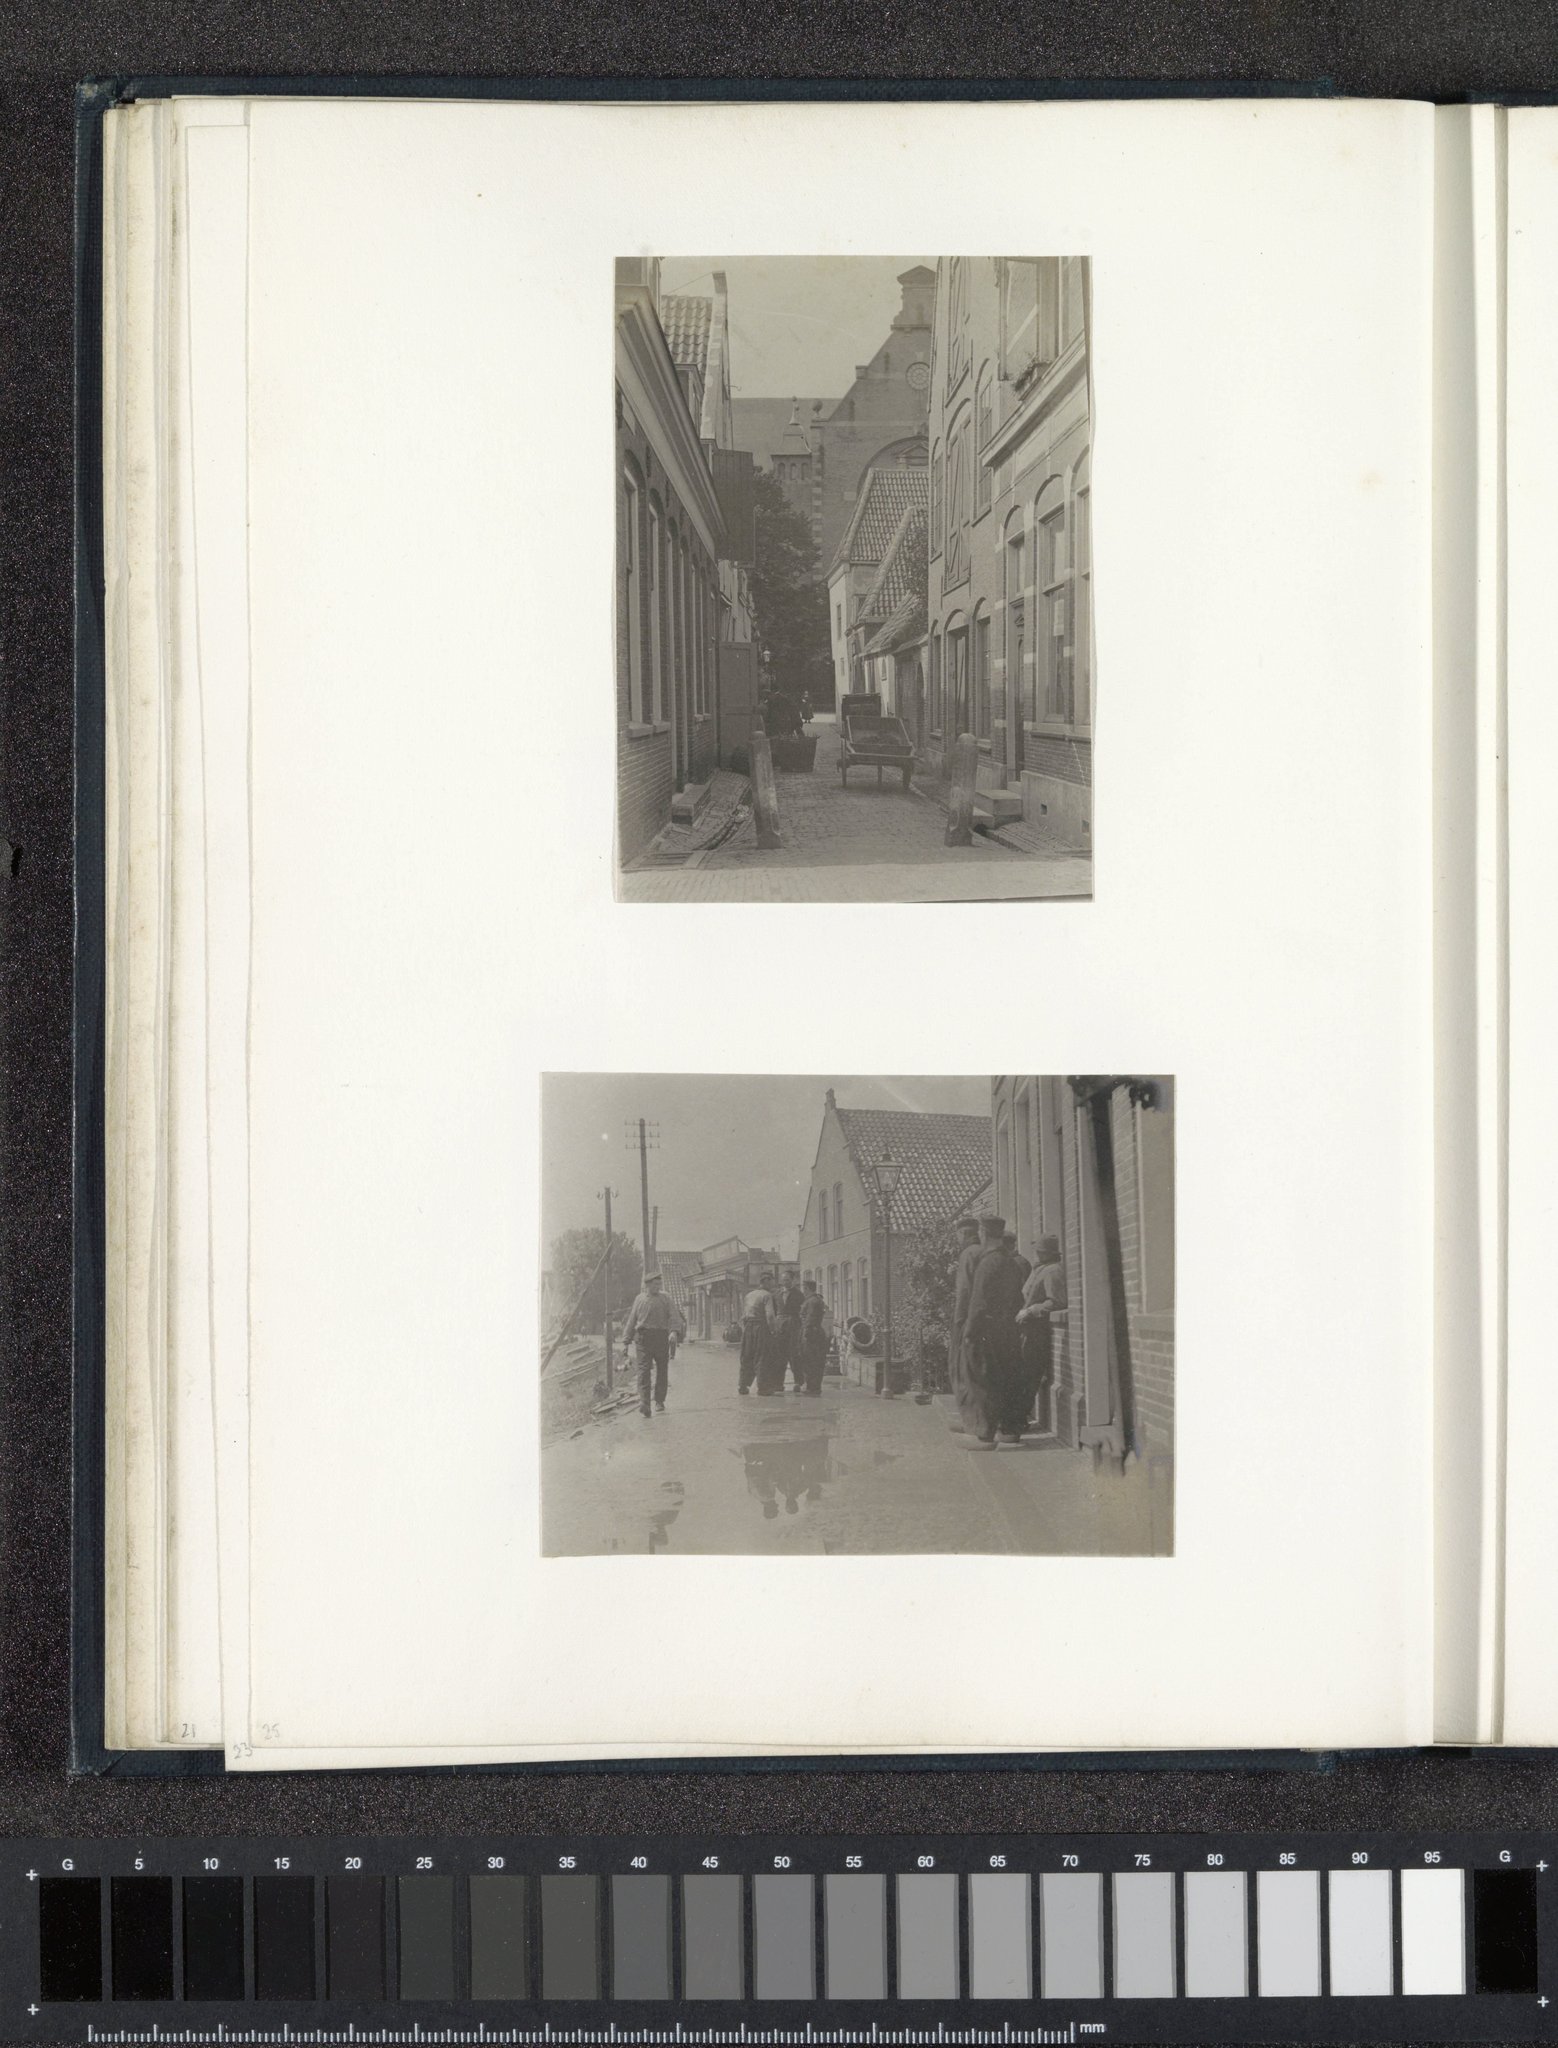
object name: photograph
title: Mannen in Volendamse kleding op een dijk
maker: george hidderley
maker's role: fotograaf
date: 1900-1910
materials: paper, photographic support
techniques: gelatin silver print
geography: volendam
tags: folk costume, regional costume (+ men's clothes), village street, dikes, levee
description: Onderdeel van fotoalbum met opnames van Volendam, Dordrecht, Gorinchem en Woudrichem.